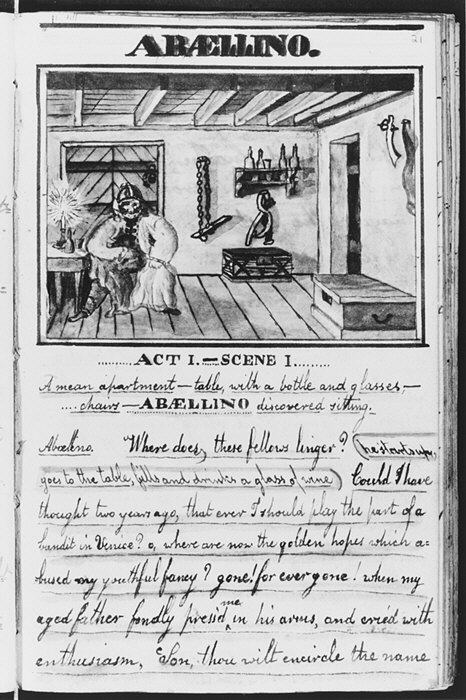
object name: album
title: Diary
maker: alexander jackson davis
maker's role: artist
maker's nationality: american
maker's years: 1803-1892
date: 1801-1900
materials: ink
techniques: pen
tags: interiors,men